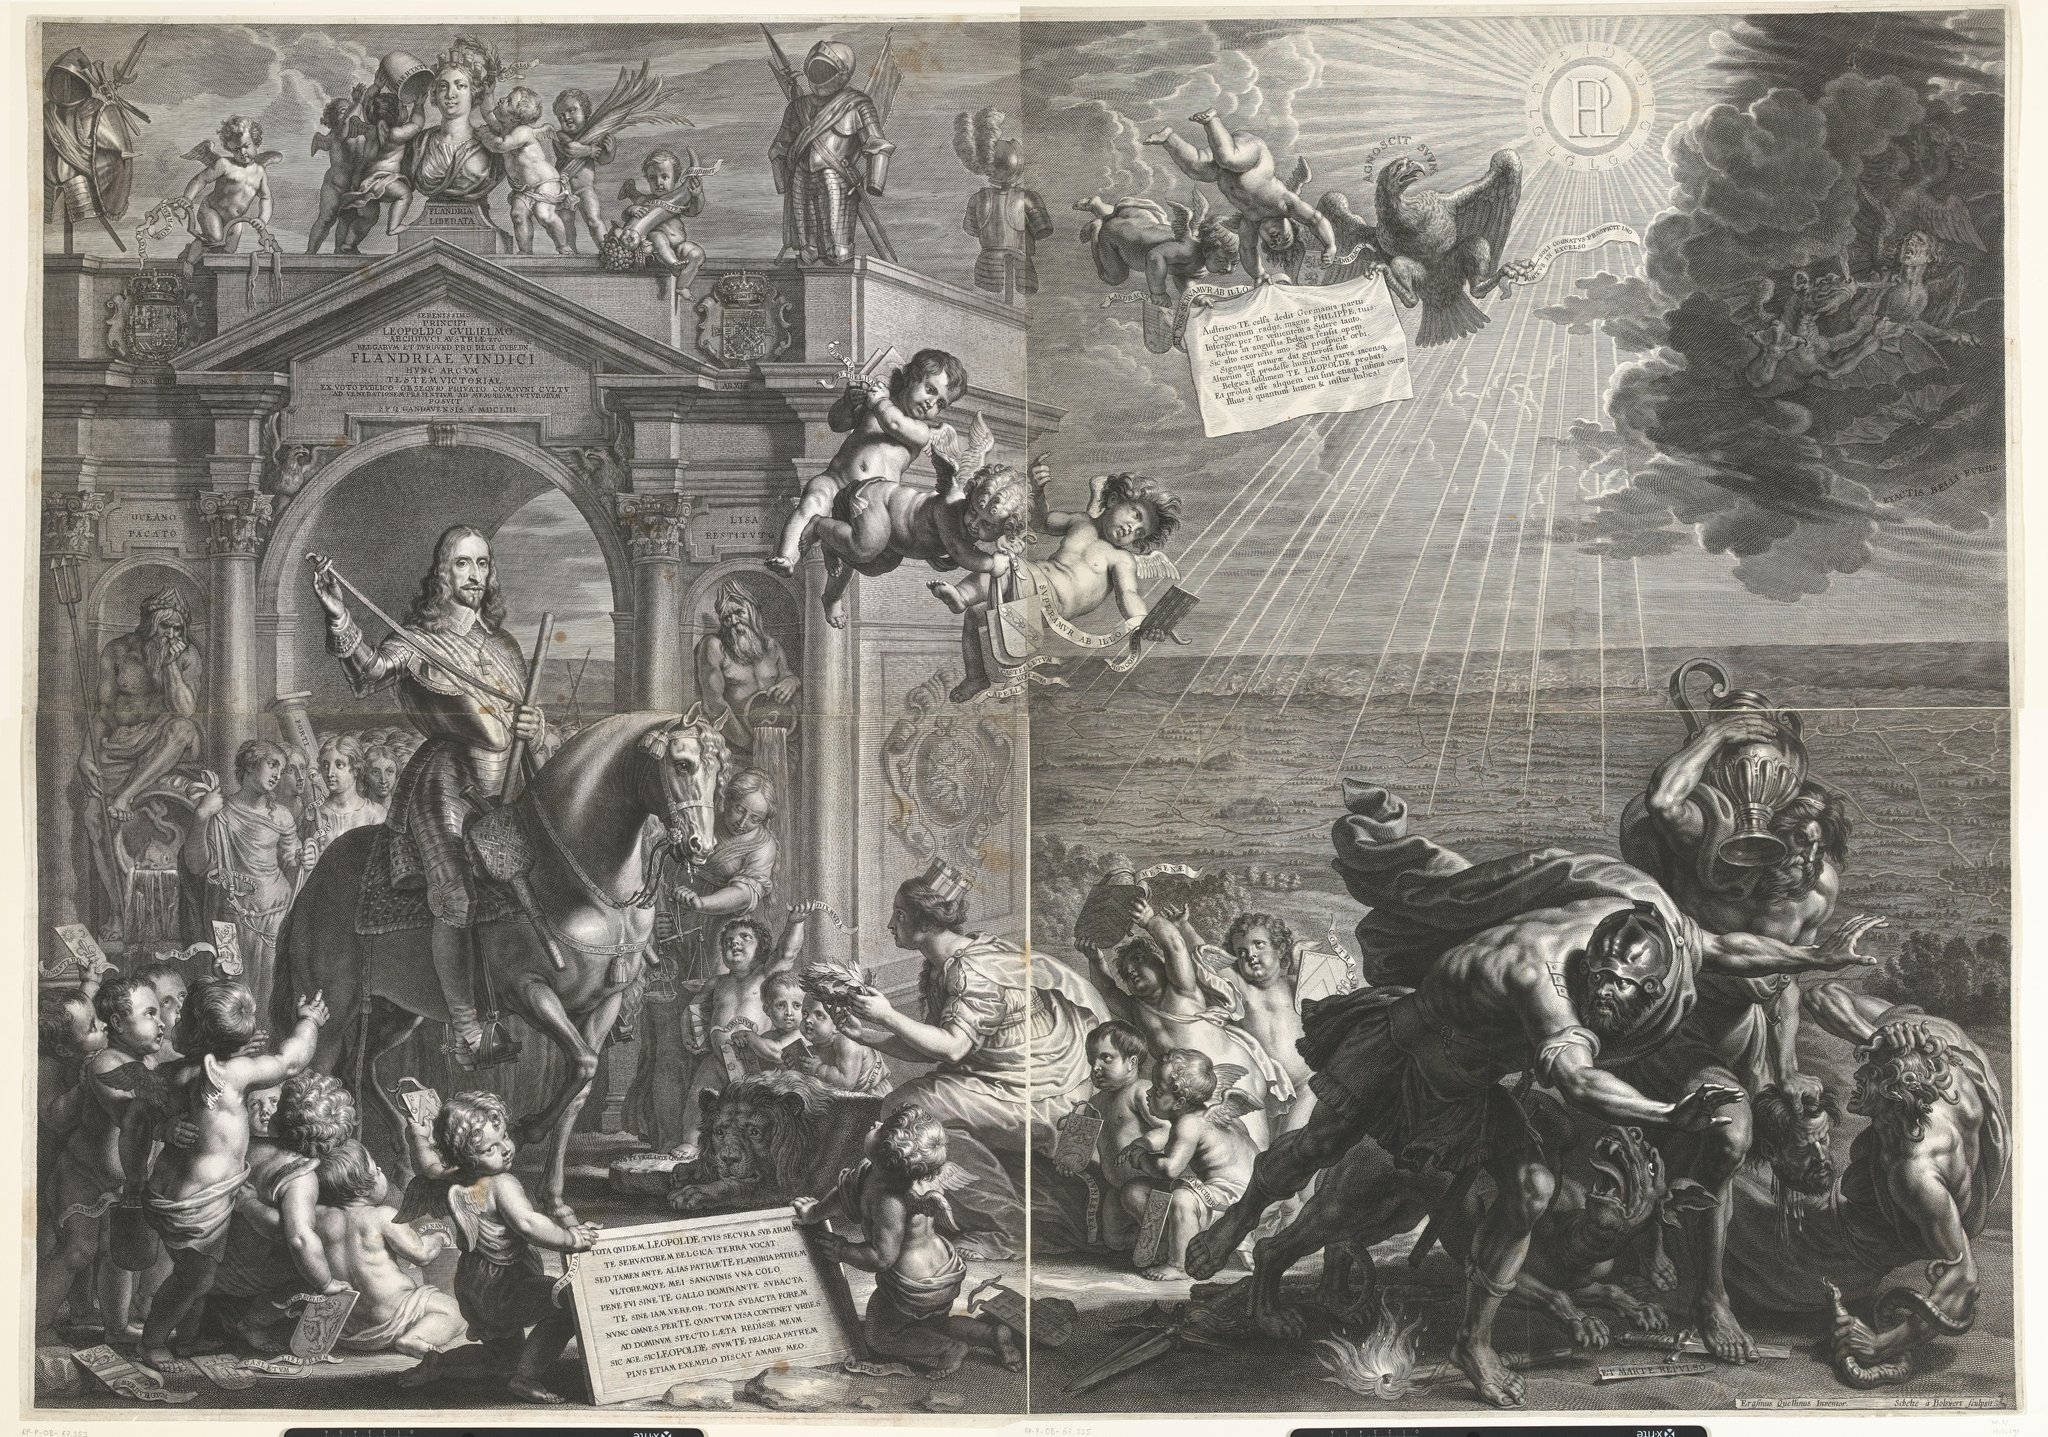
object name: print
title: Intocht van Leopold Willem, landvoogd der Zuidelijke Nederlanden, te Gent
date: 1653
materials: paper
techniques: engraving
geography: antwerp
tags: vienna, leopold willem van oostenrijk (landvoogd der zuidelijke nederlanden), equestrian state-portrait, conqueror triumphing, triumphal entry of victor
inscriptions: collector's mark: Lugt 240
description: Intocht van Leopold Willem, landvoogd der Zuidelijke Nederlanden, te Gent. Prent bestaande uit vier delen. Leopold Willem te paard komt door een triomfboog de stad binnen waar hij ontvangen wordt door putti met de wapenschilden van de verschillende steden in de Zuidelijke Nederlanden. De Gentse stedenmaagd heet hem welkom. Rechts vluchten de vijanden en plunderaars.